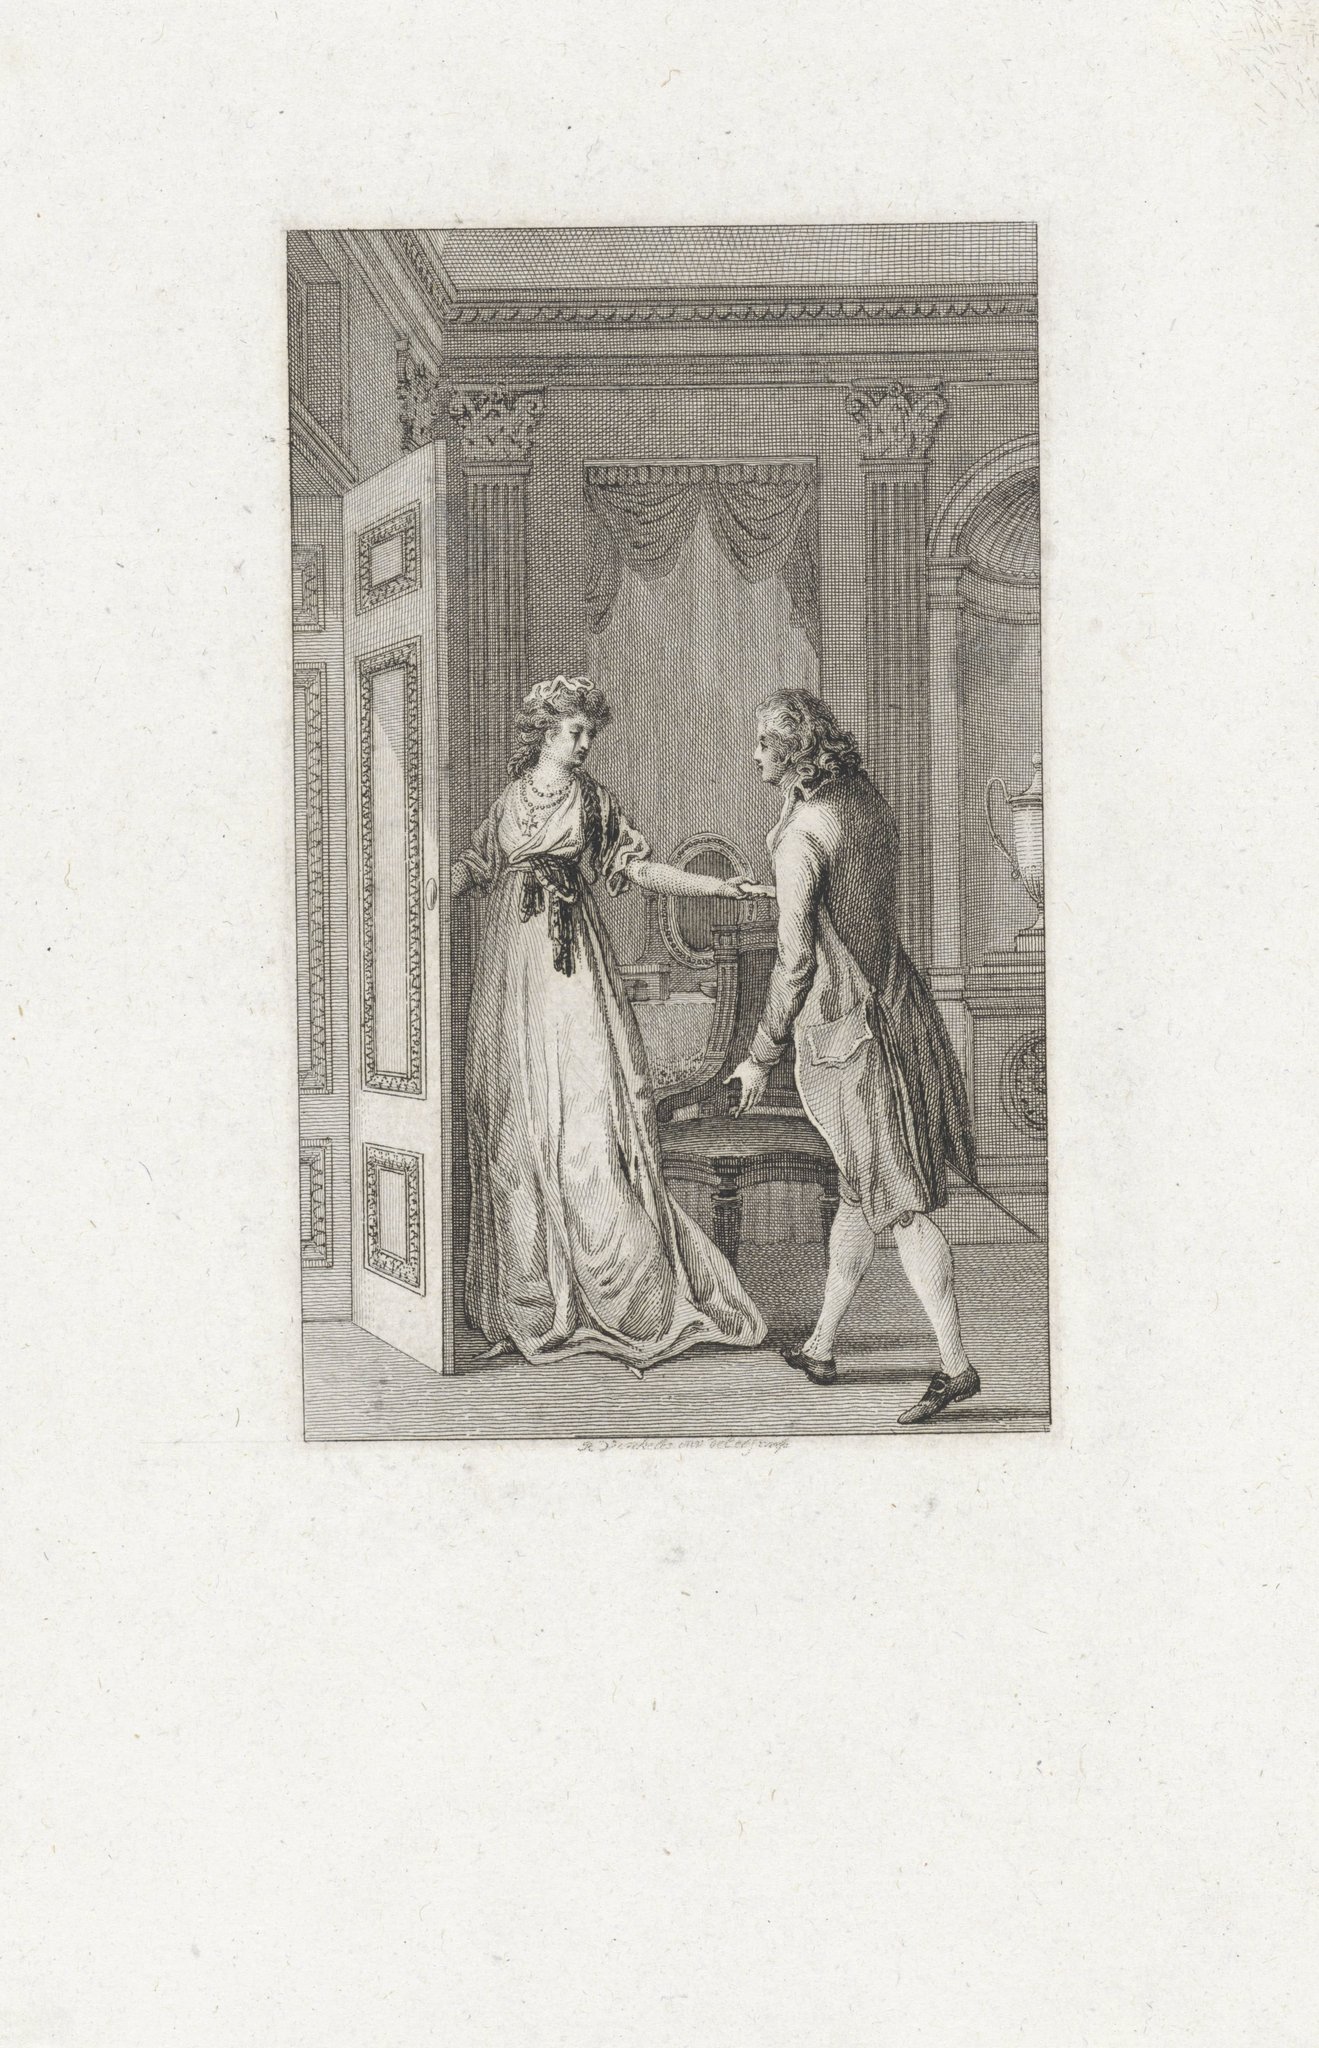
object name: print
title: Vrouw houdt de deur open voor een man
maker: reinier vinkeles (i)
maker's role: draughtsman, print maker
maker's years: 1741-1816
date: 1800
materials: paper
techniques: engraving, etching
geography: amsterdam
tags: open door, letter, envelope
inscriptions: collector's mark: Lugt 240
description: Illustratie uit: Richardson, Samuel. Geschiedenis van Karel Grandison. Amsterdam: Johannes Allart, 1797-1802.